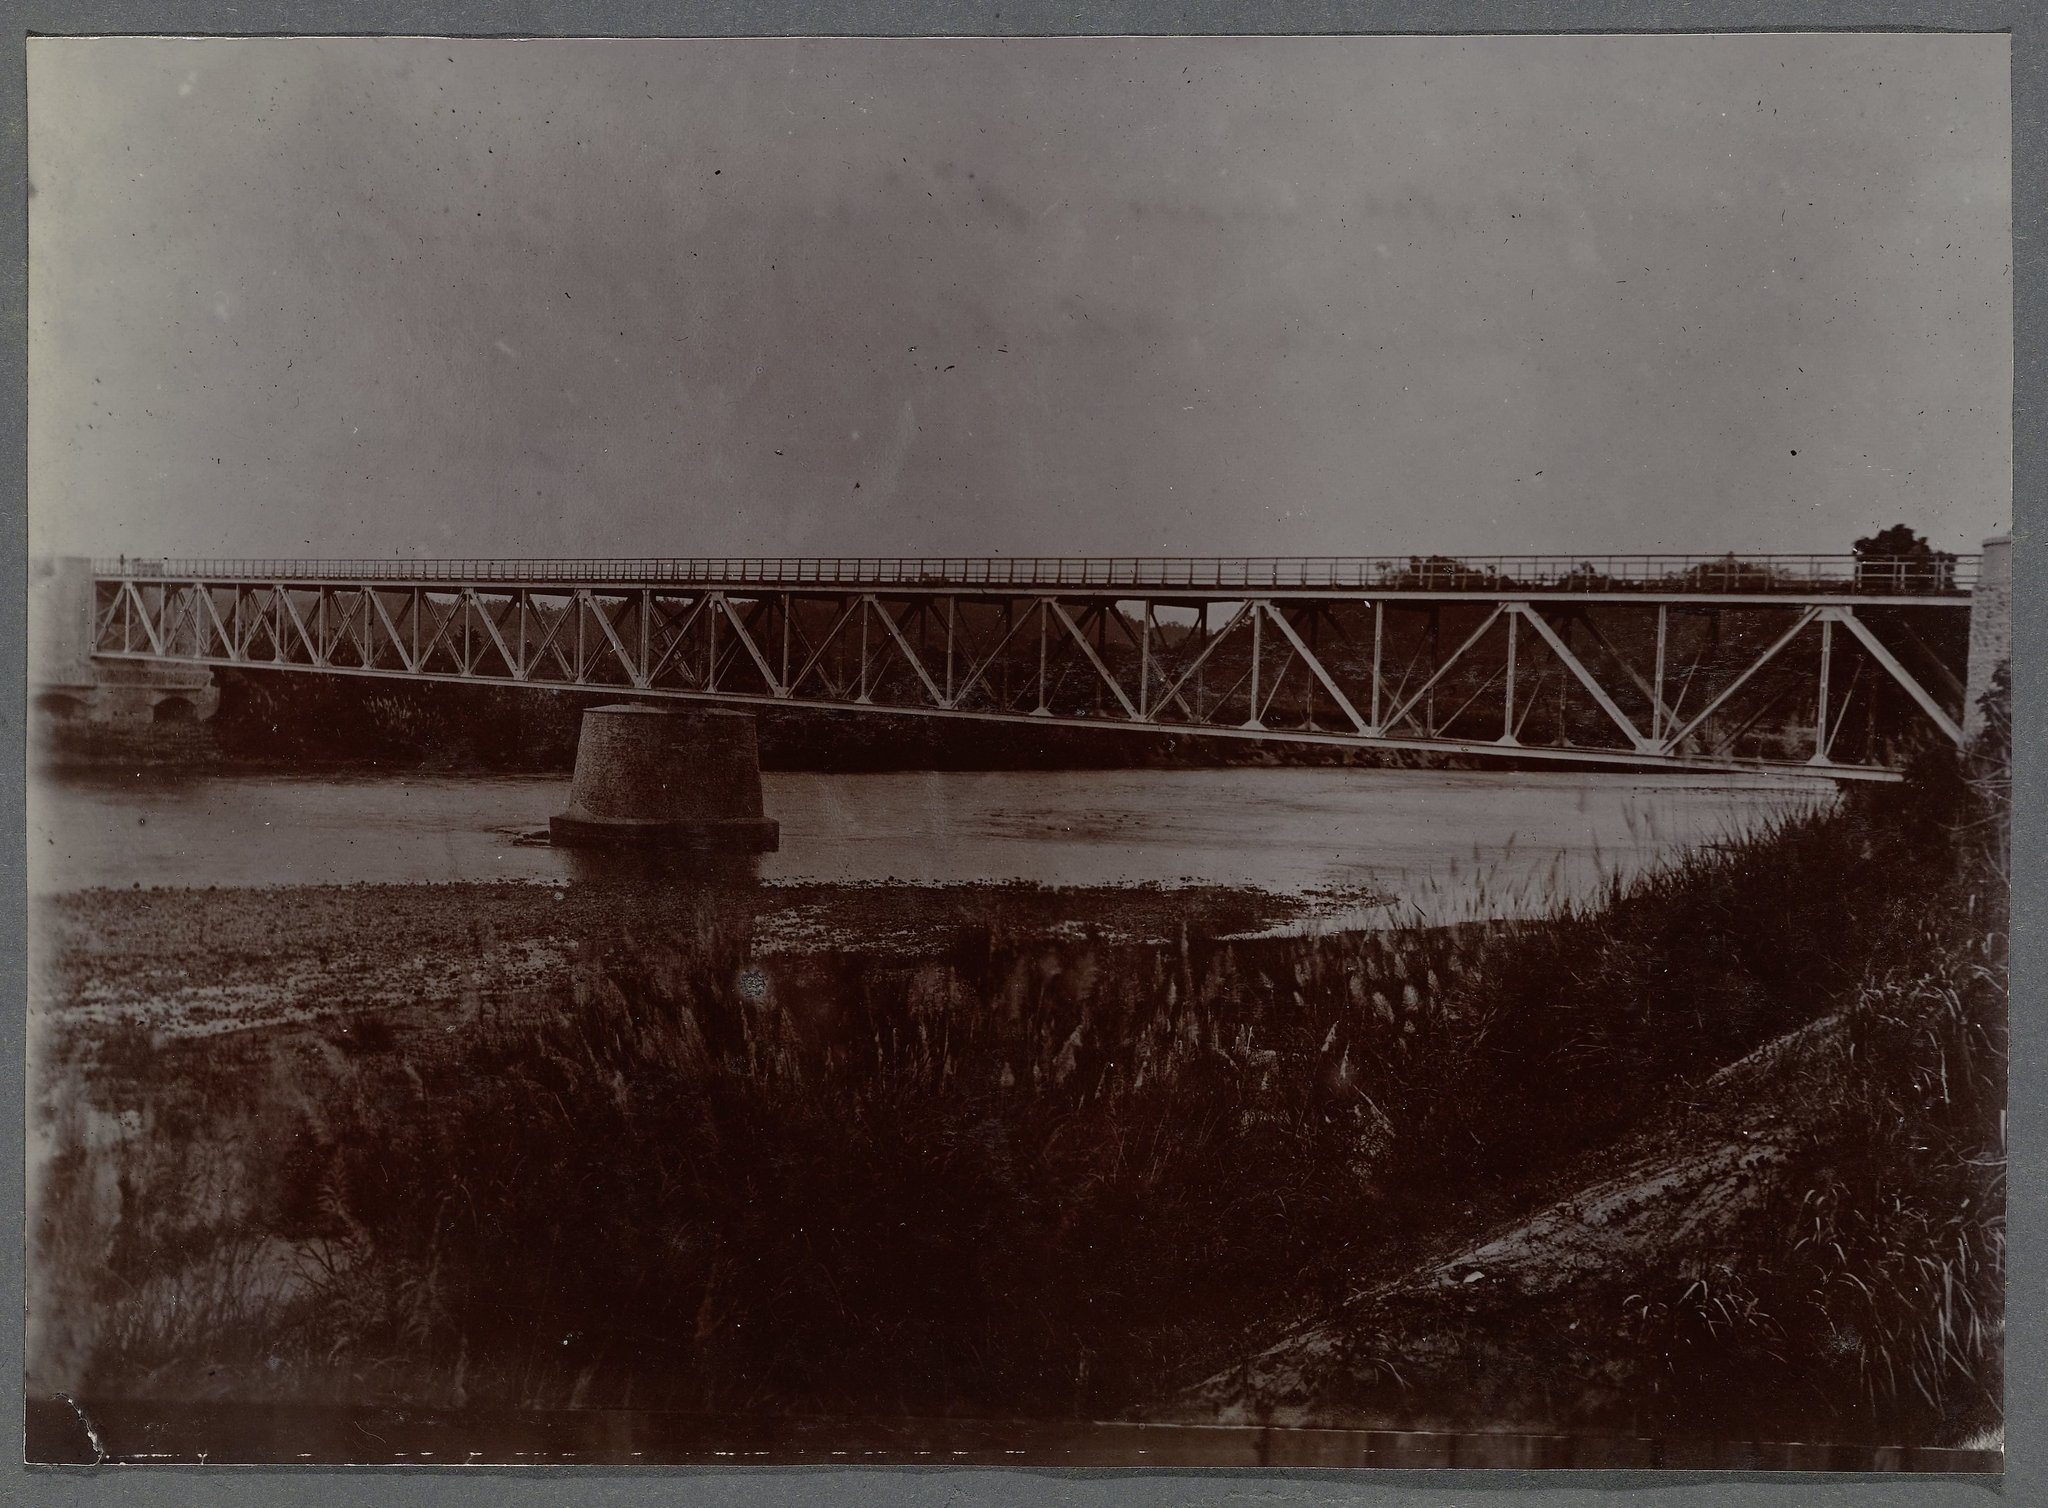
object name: photograph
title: Big Brifdge at Teupin Blang Mane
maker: Anonymous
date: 1903-1913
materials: photographic support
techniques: gelatin silver print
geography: north sumatra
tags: arnhem, the hague, albertus dominicus laman trip, building activities, traffic by road or path with motor-vehicle, landscapes in tropical and sub-tropical regions, road, path, bridge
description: Na de expedities naar de Gajo- en Alaslanden o.l.v. Van Daalen (eerste tocht in 1901), werd hij in 1903 belast met voorbereiding van permanente vestiging van Nederlands gezag. Aanleg van een weg van de Noordkust naar het binnenland was hierbij van groot belang. Deze zgn. Gajoweg werd aangelegd tussen 1903 en 1914, van Bireuen aan de kust naar Takinguen aan het bergmeer Danau Lauttawar, totale lengte 104 km.